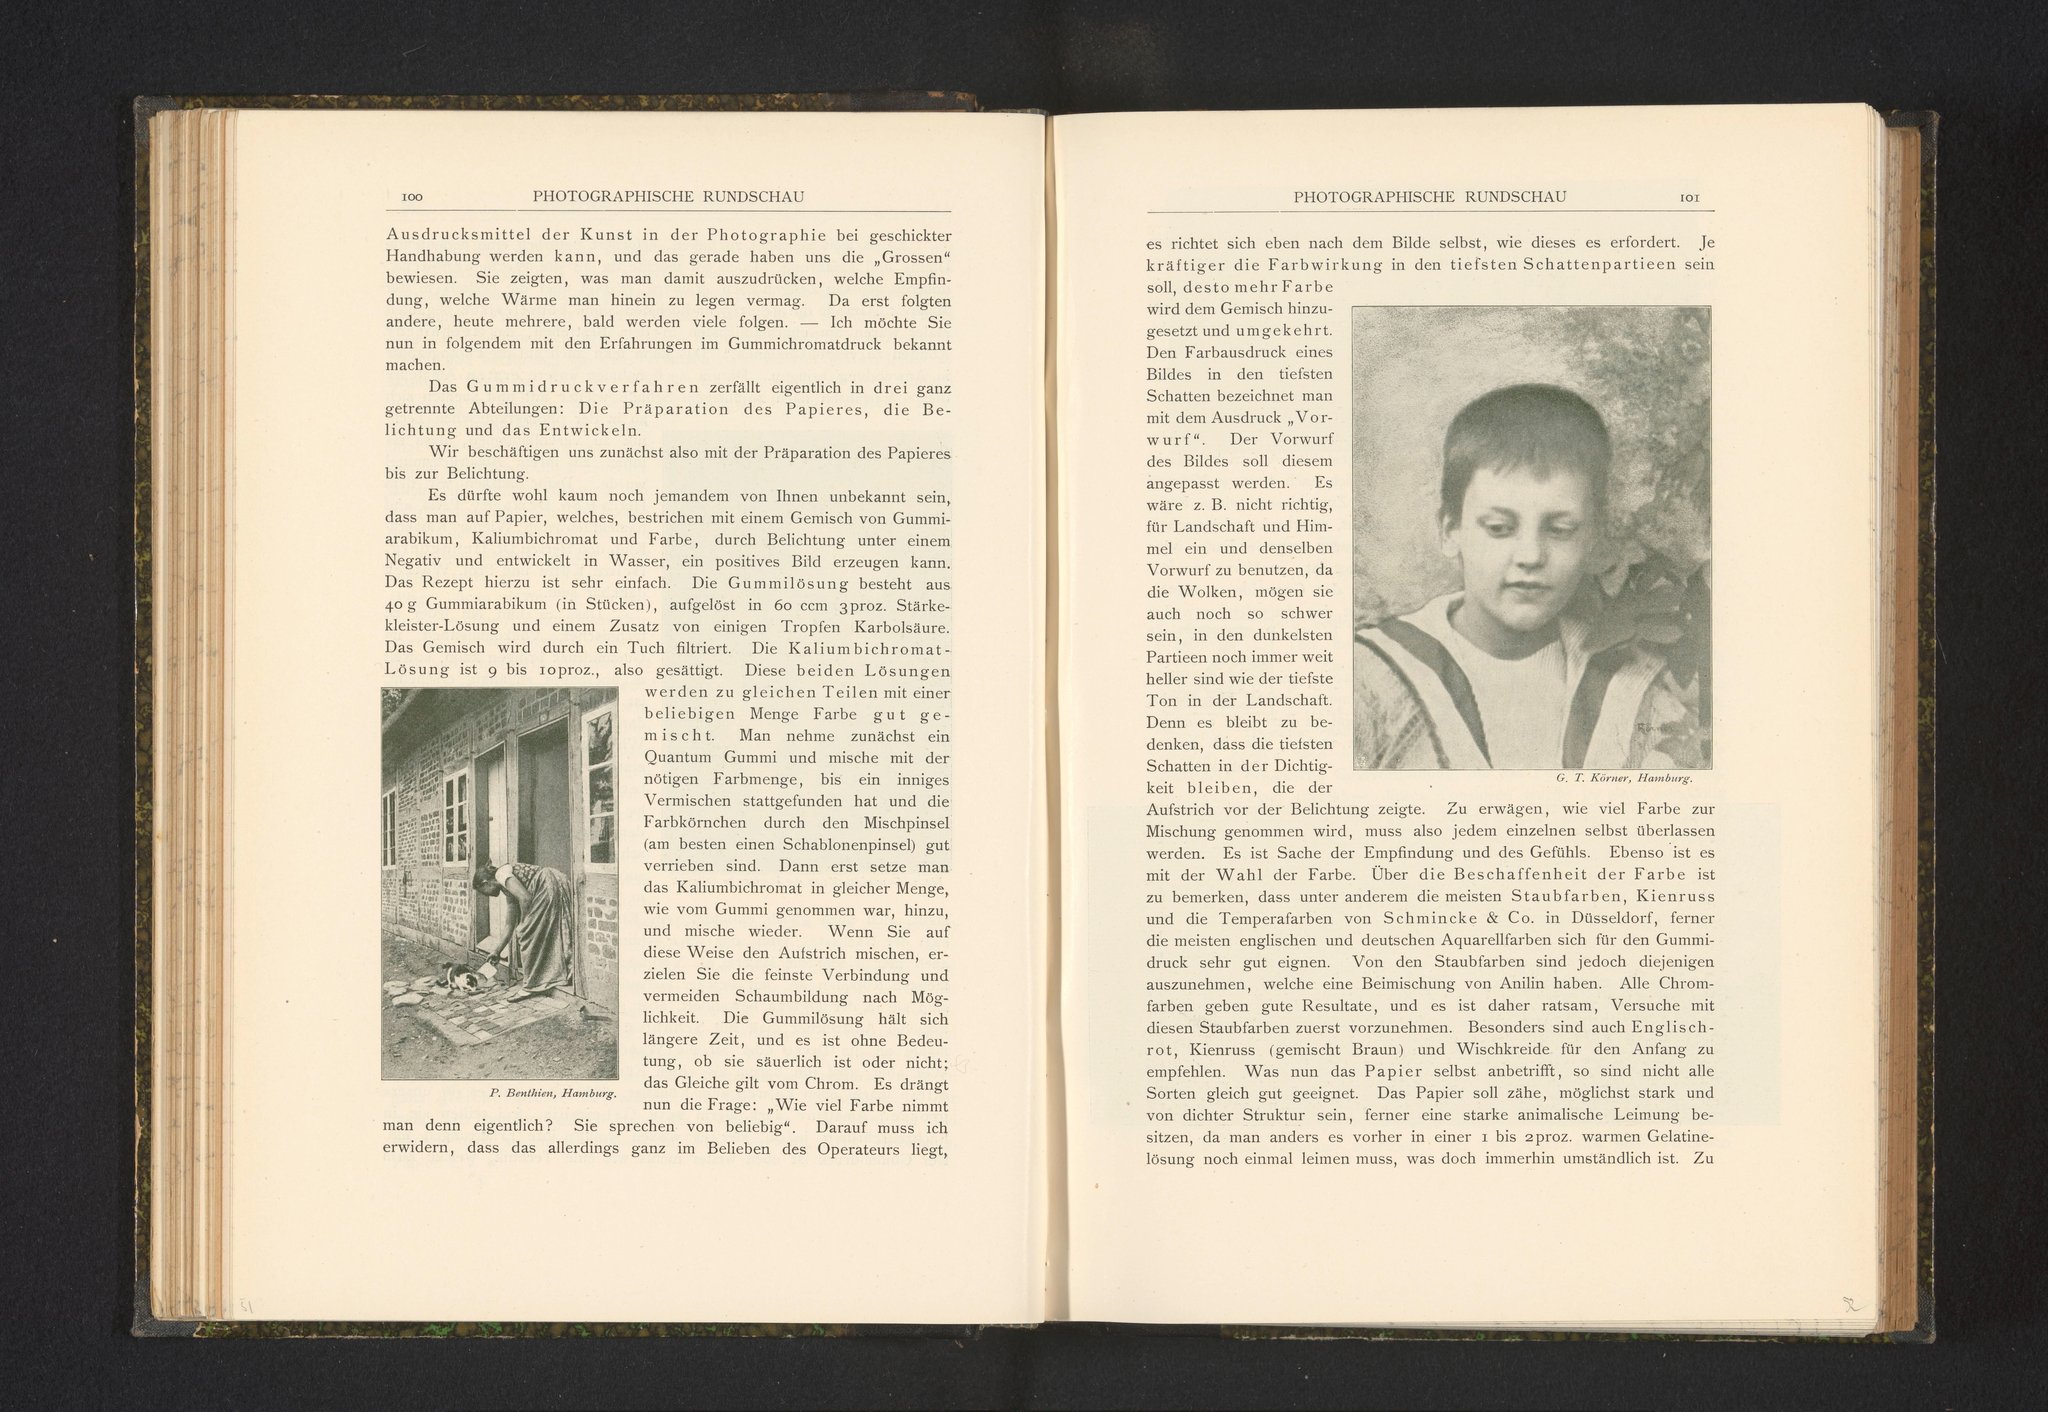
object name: photomechanical print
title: Portret van een onbekende jongen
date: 1893-1898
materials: paper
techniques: autotype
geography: hamburg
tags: boy (child between toddler and youth)